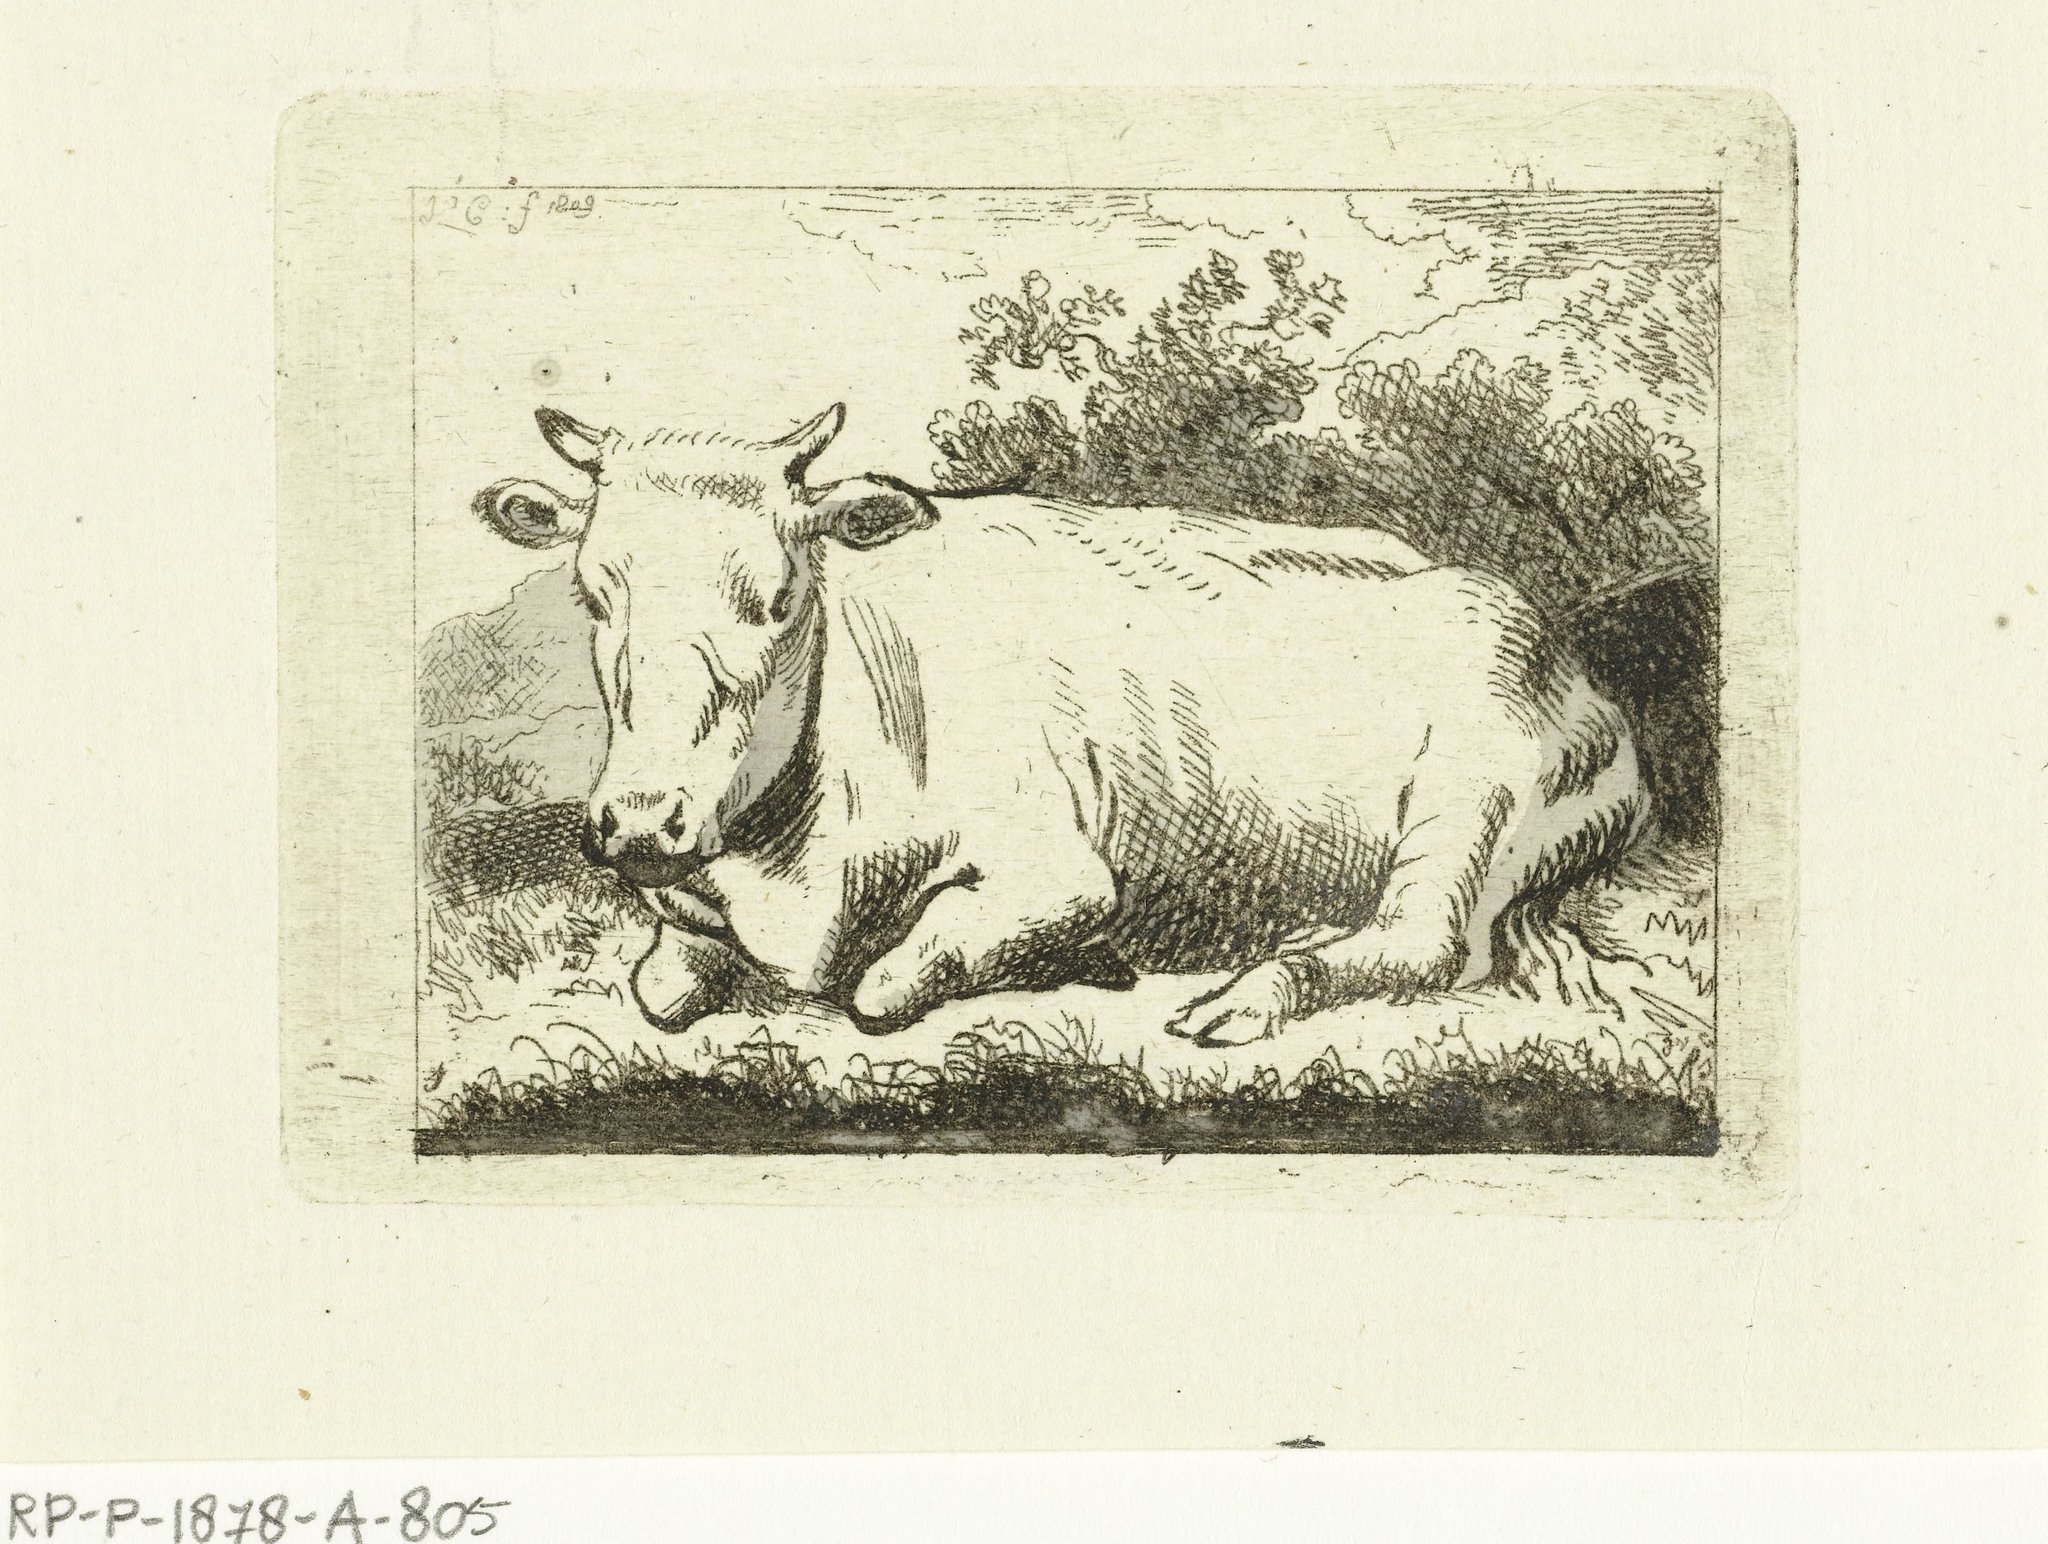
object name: print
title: Liggende koe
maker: johannes van cuylenburgh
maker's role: print maker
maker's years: 1793-1841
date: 1809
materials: paper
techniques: brush, etching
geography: netherlands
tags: cow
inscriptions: collector's mark: Lugt 2228